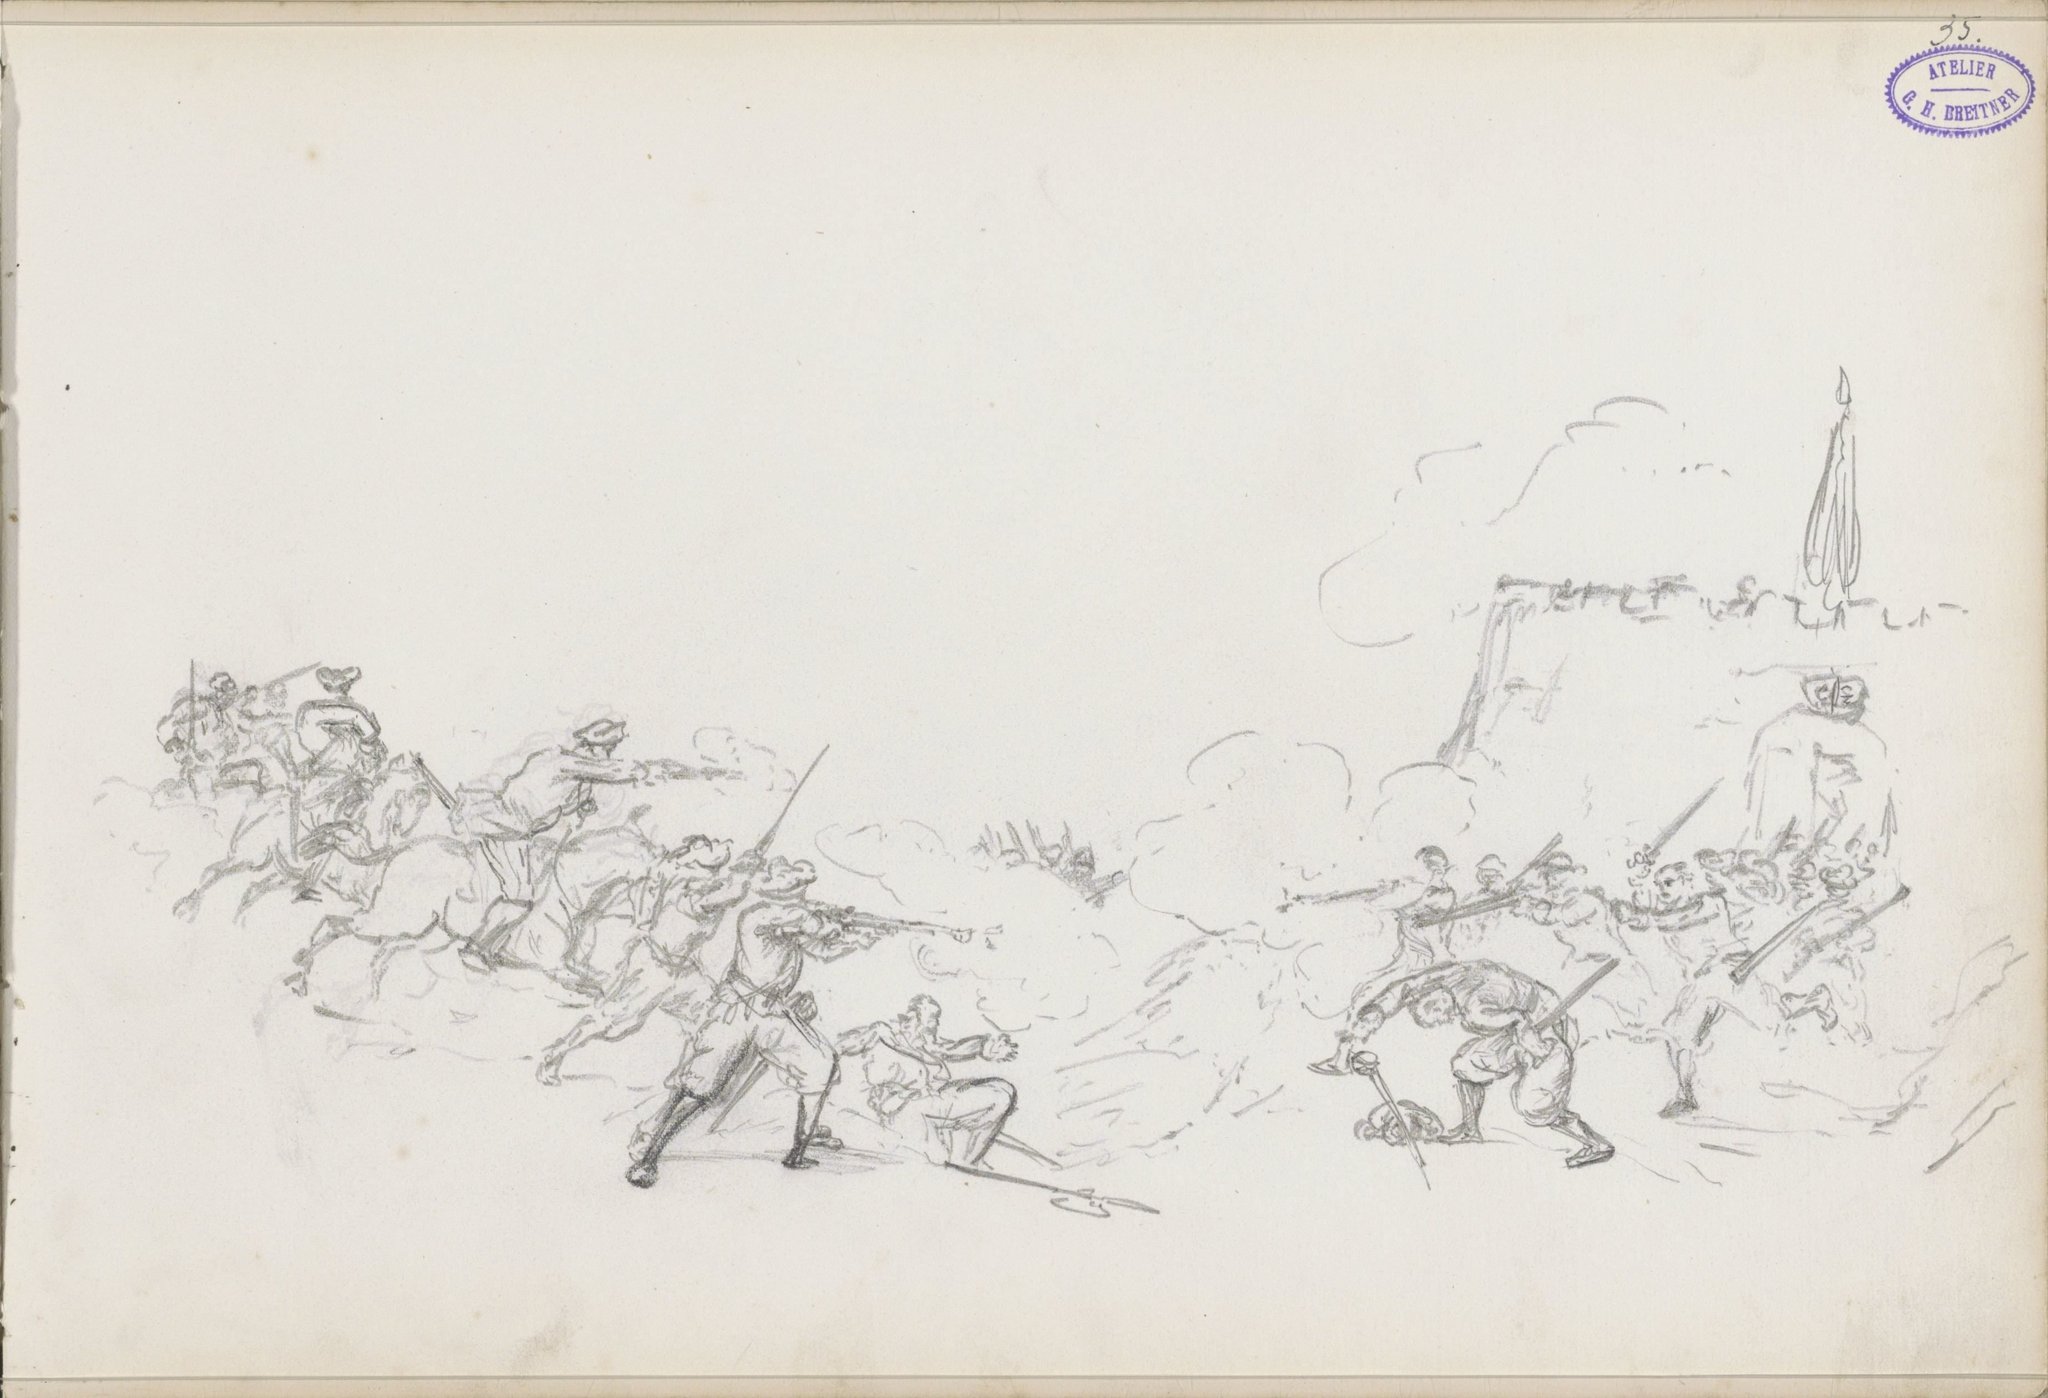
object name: sketchbook leaf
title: Strijdende soldaten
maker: george hendrik breitner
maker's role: draughtsman, painter, print maker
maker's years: 1857-1923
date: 1809-1872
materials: paper, pencil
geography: rotterdam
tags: division of armed forces (+ during the battle), division of armed forces (+ land forces), church (exterior)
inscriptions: workshop stamp: Lugt 291d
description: Op de achtergrond mogelijk een kerk. Blad 35 uit een schetsboek met 32 bladen.